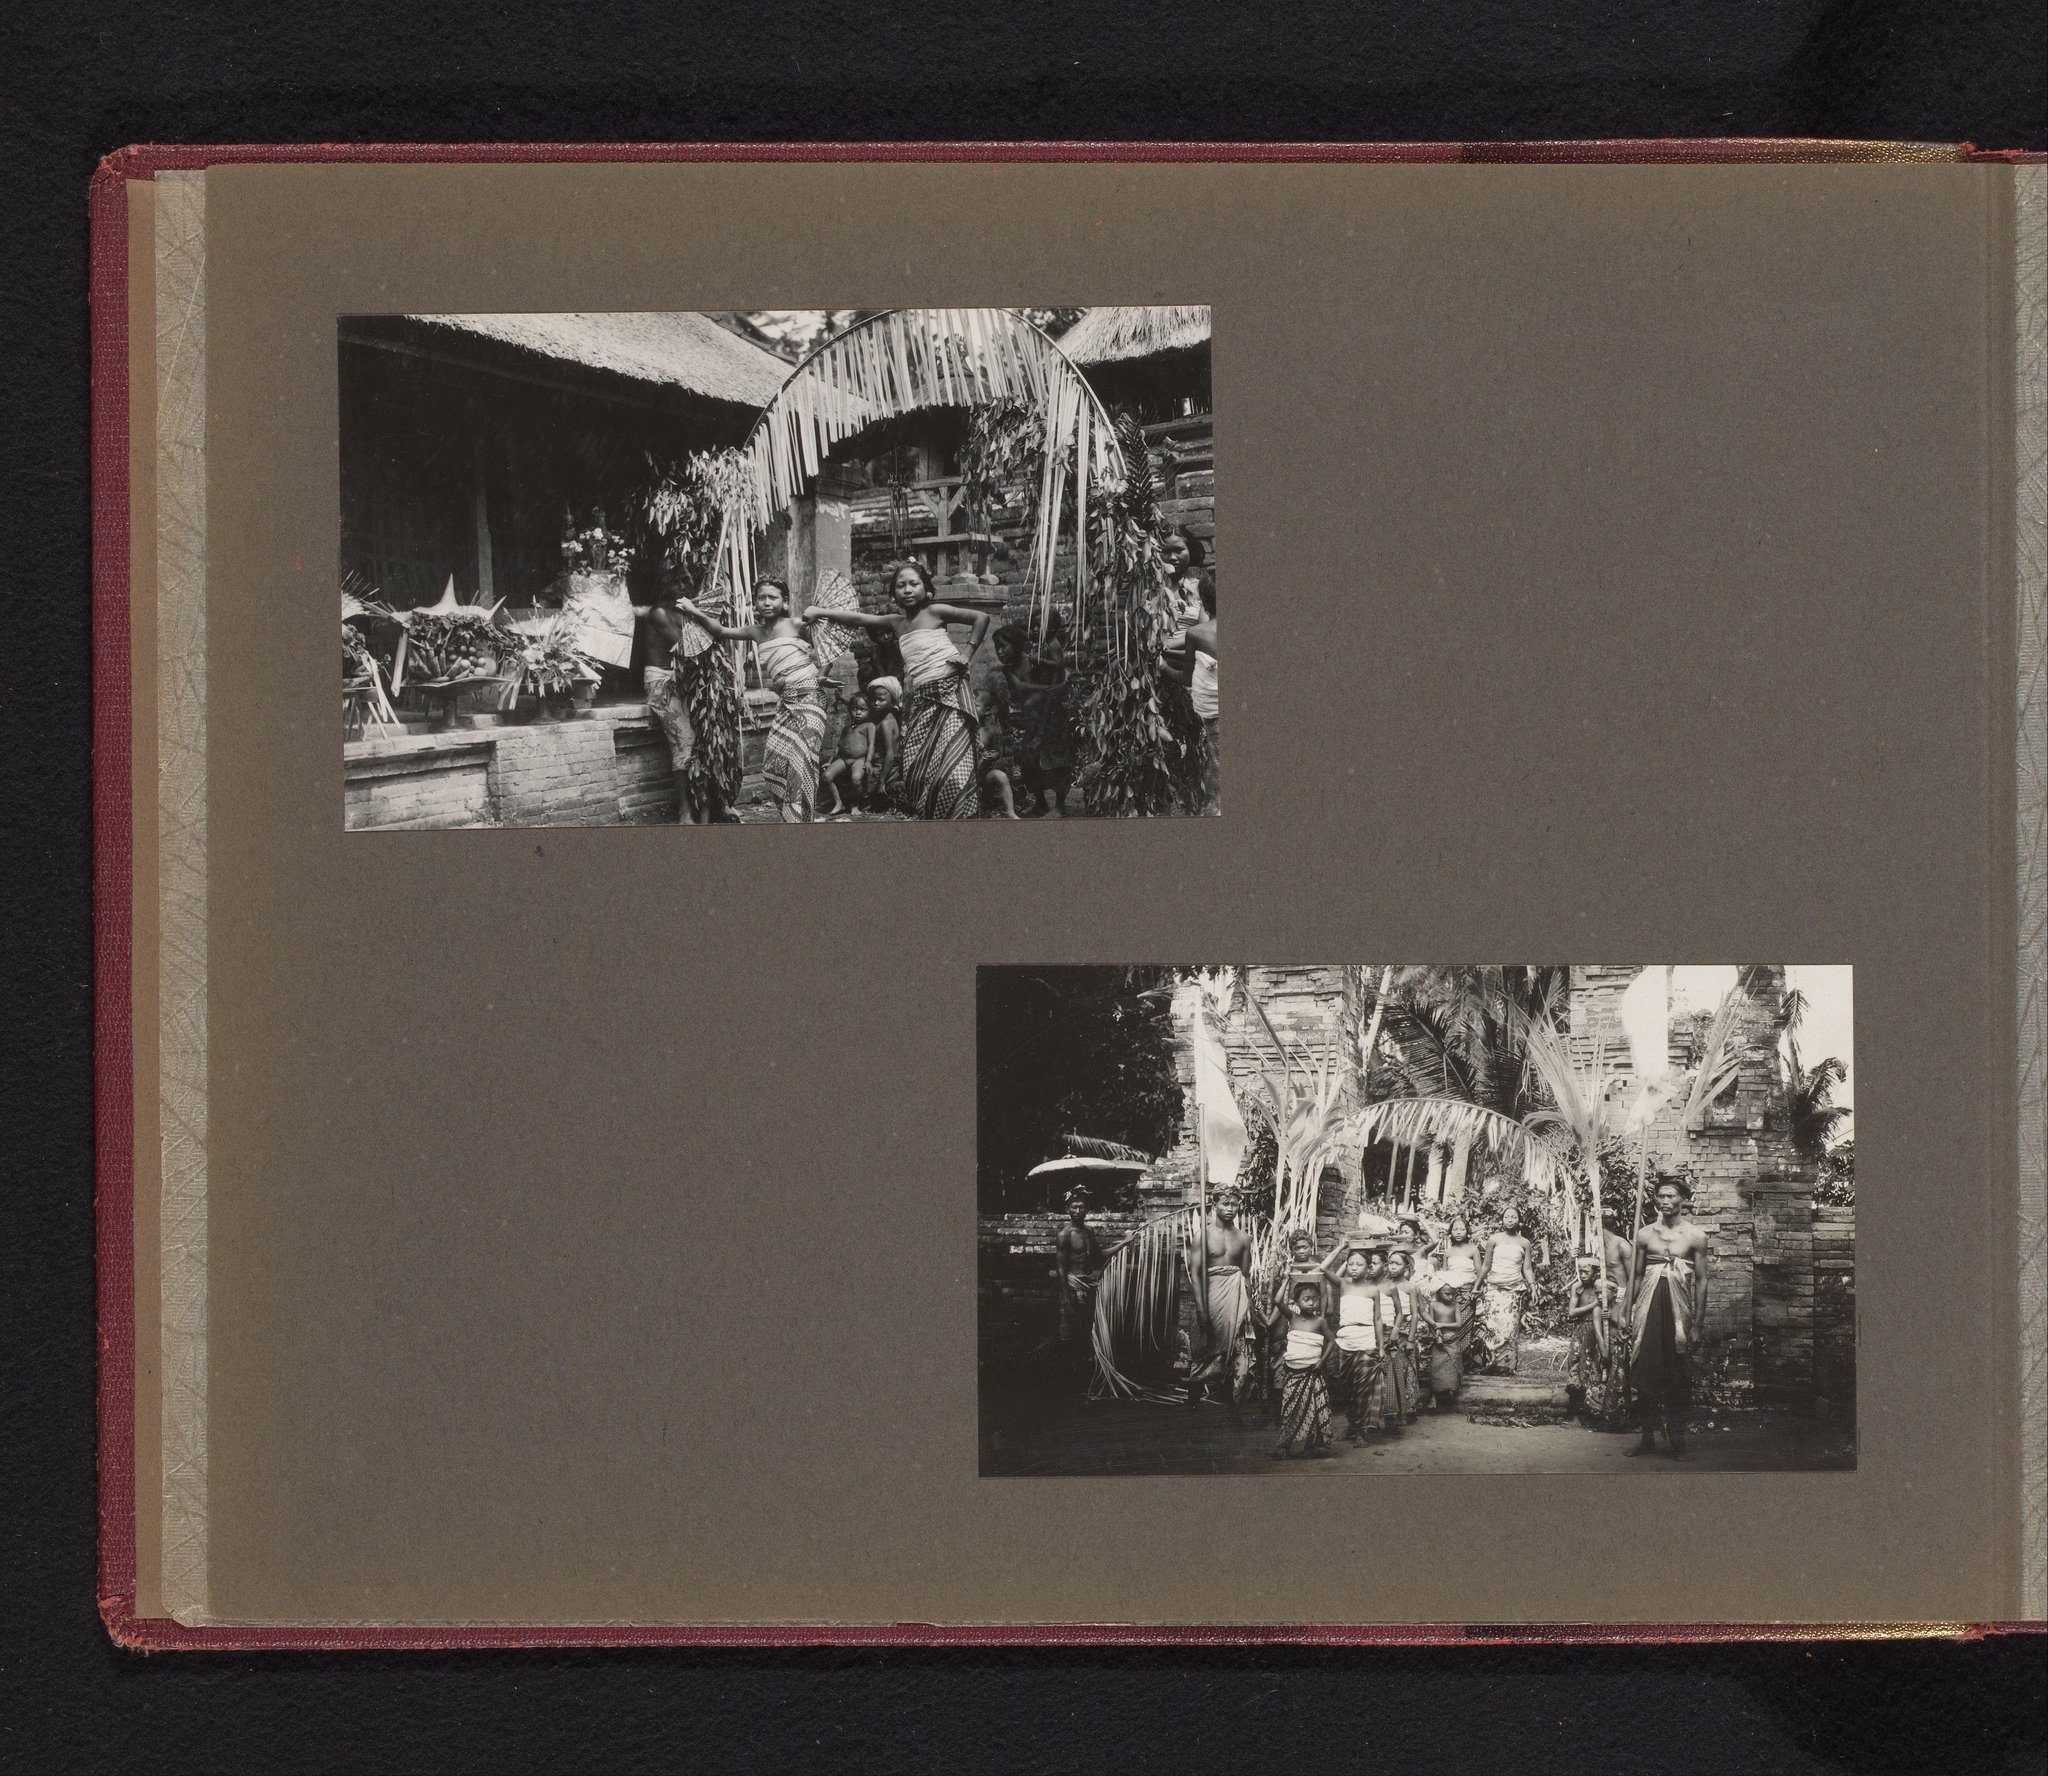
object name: album leaf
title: Traditionele dans met waaier, uitgevoerd door twee meisjes en Groep mannen, jongens en meisjes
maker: Anonymous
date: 1950-1960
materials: photographic support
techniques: gelatin silver print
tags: adolescent, young woman, maiden, boy (child between toddler and youth), girl (child between toddler and youth), folk costume, regional costume, dutch east indies, the